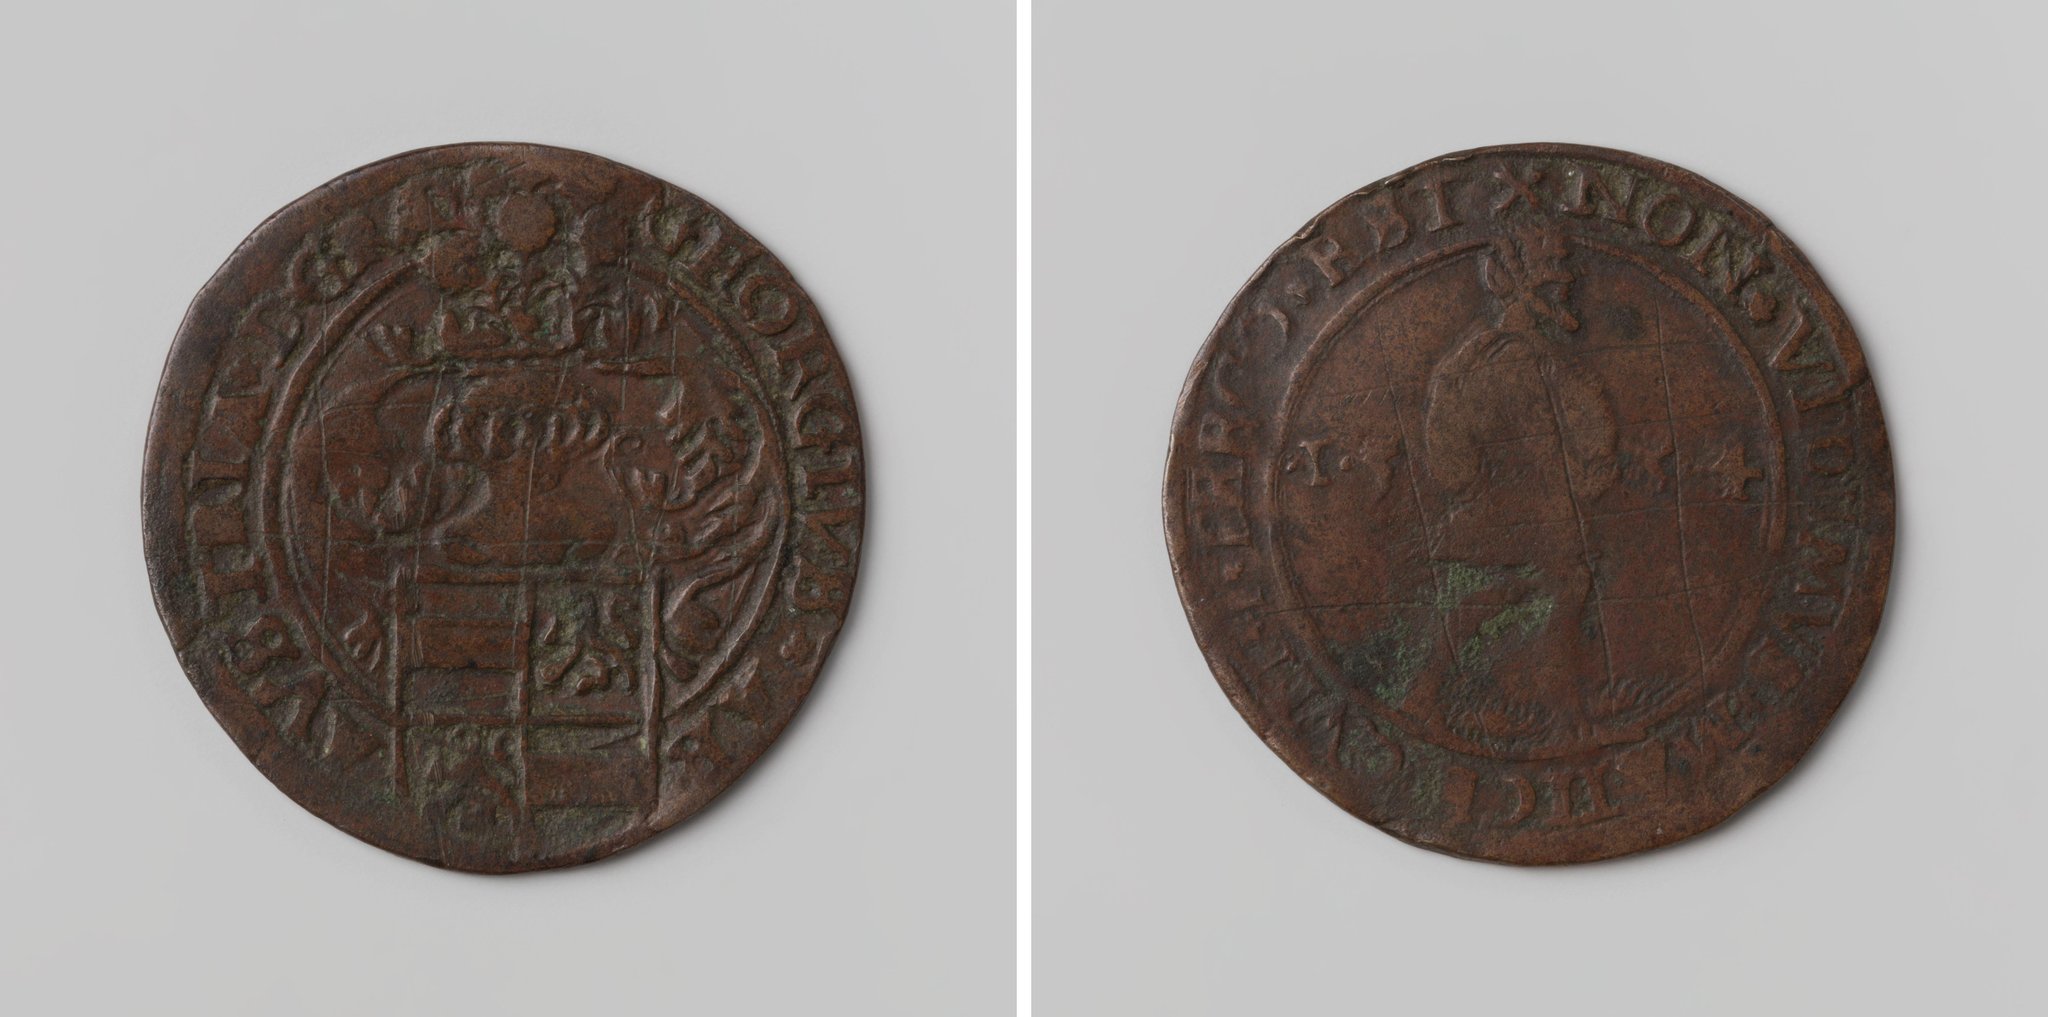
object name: jeton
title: George I van Oostenrijk, prins-bisschop van Luik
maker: Anonymous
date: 1554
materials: copper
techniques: striking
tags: liège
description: Koperen penning. Voorzijde: gehelmd wapenschild onder kroon met pluimen binnen omschrift. Keerzijde: man met zak over schouder tussen jaartal binnen omschrift